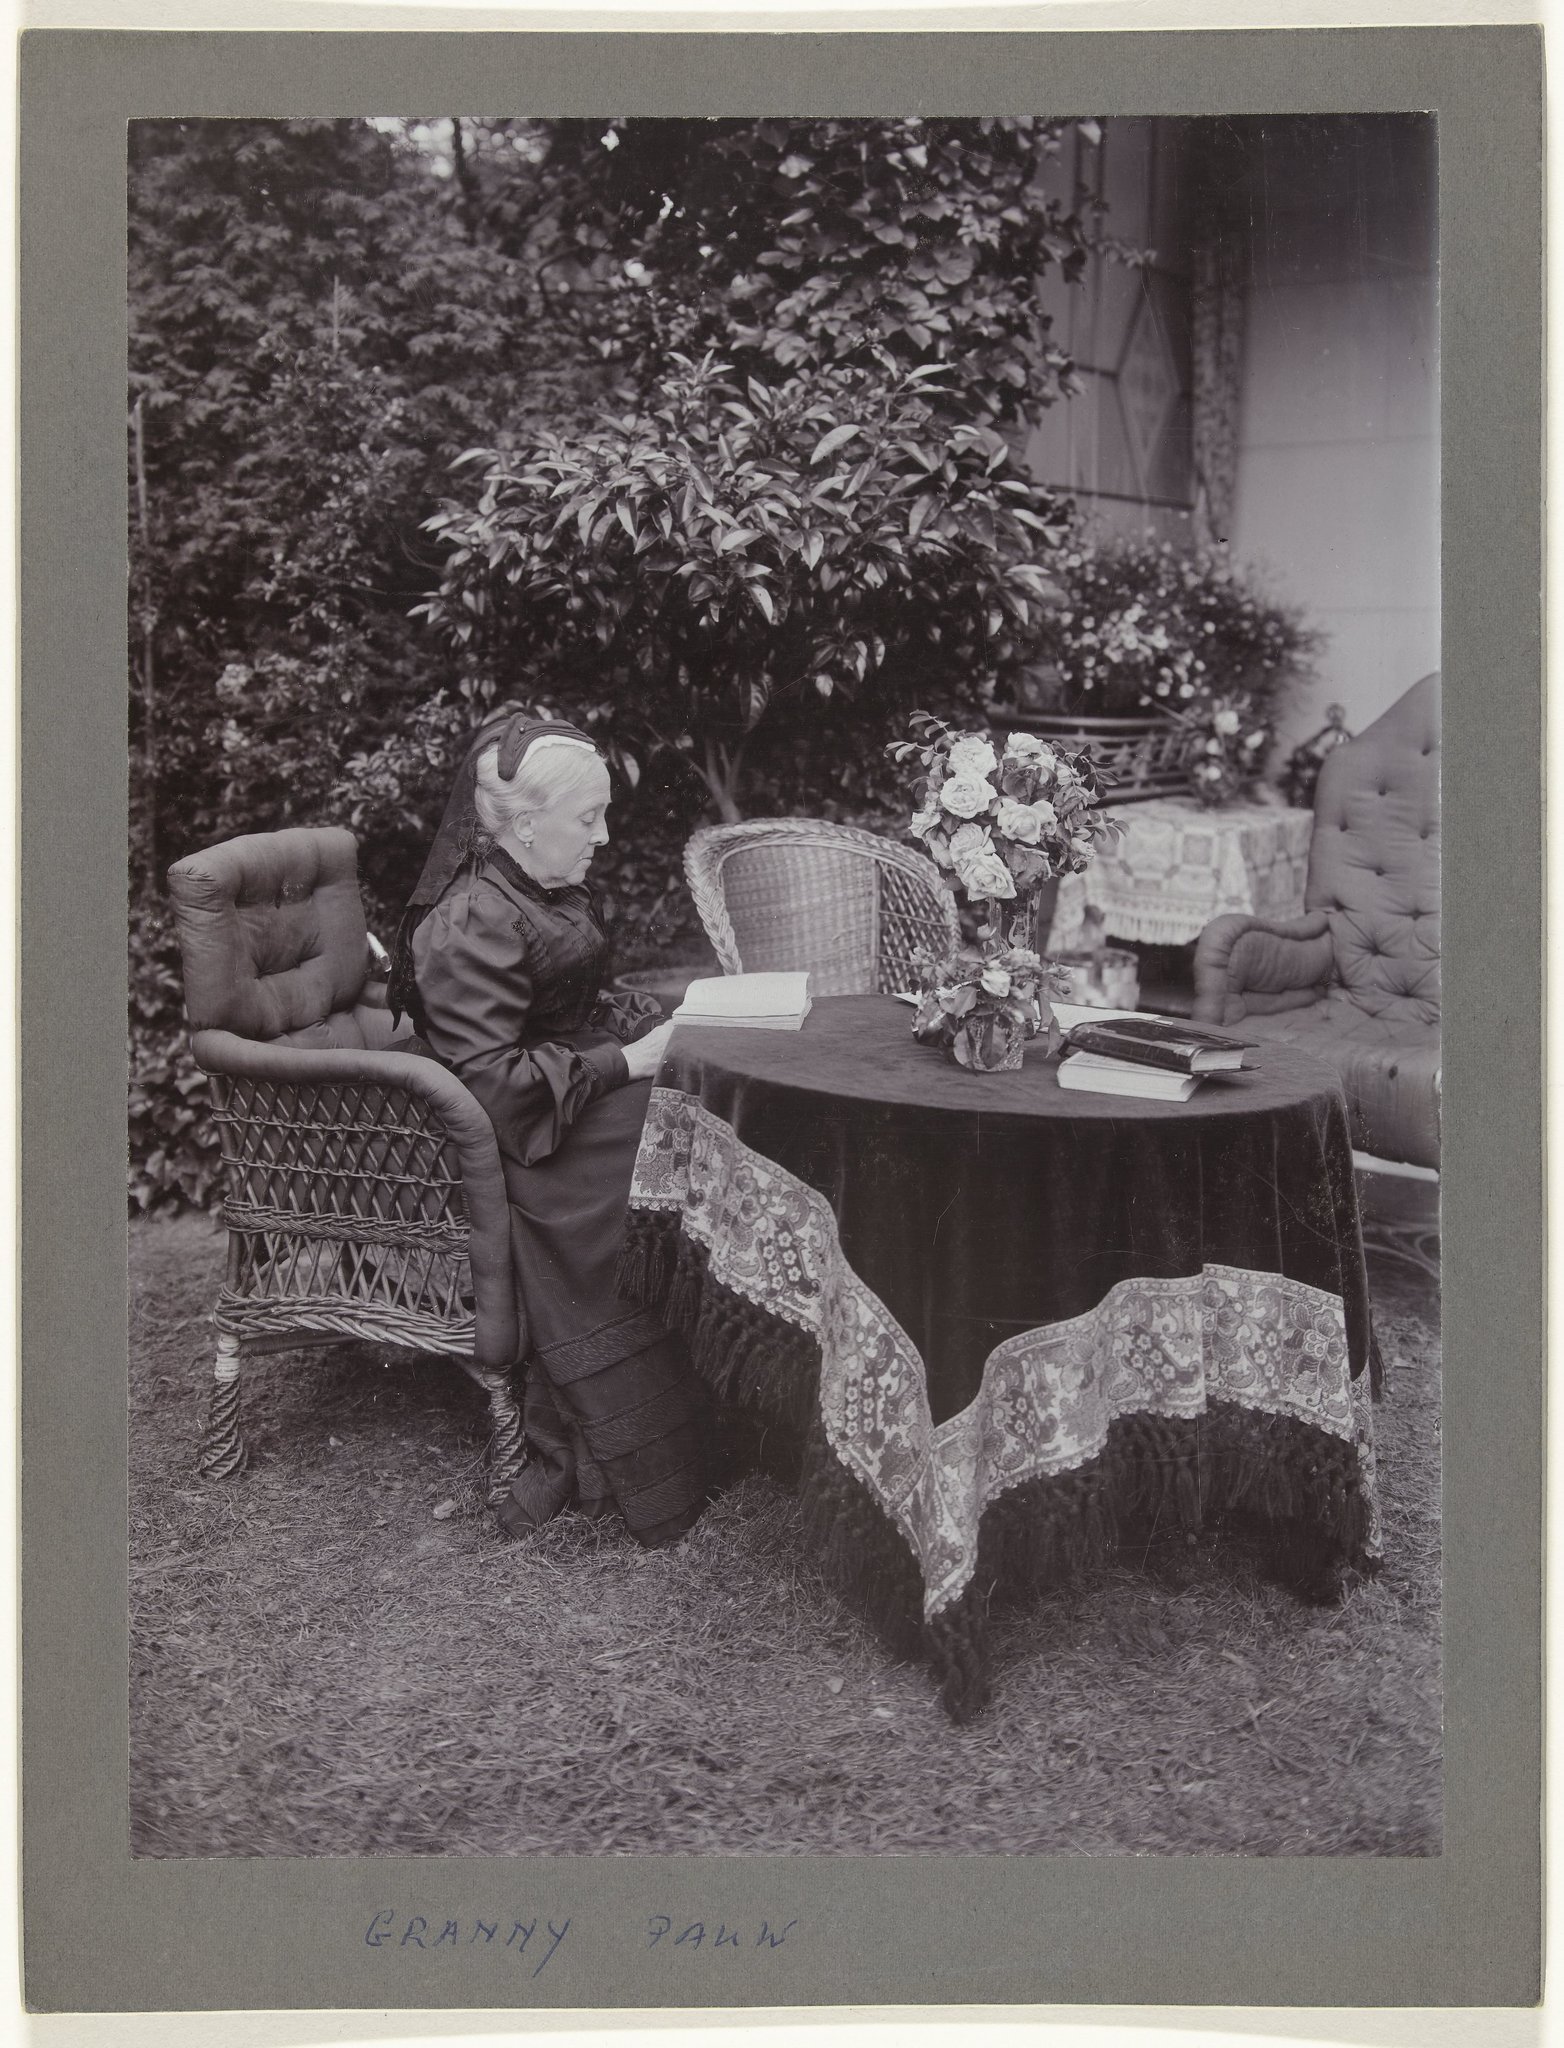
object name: photograph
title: Aletta Cornelia Anna Voombergh (1828-1913), moeder van de fotograaf, lezend aan een tafel achter het huis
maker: henry pauw van wieldrecht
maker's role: fotograaf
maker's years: 1863-1912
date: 1905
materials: cardboard, photographic support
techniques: collodion silver print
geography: netherlands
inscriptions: annotation: ‘No 2946. / 1905.’, annotation: ‘Granny Pauw’